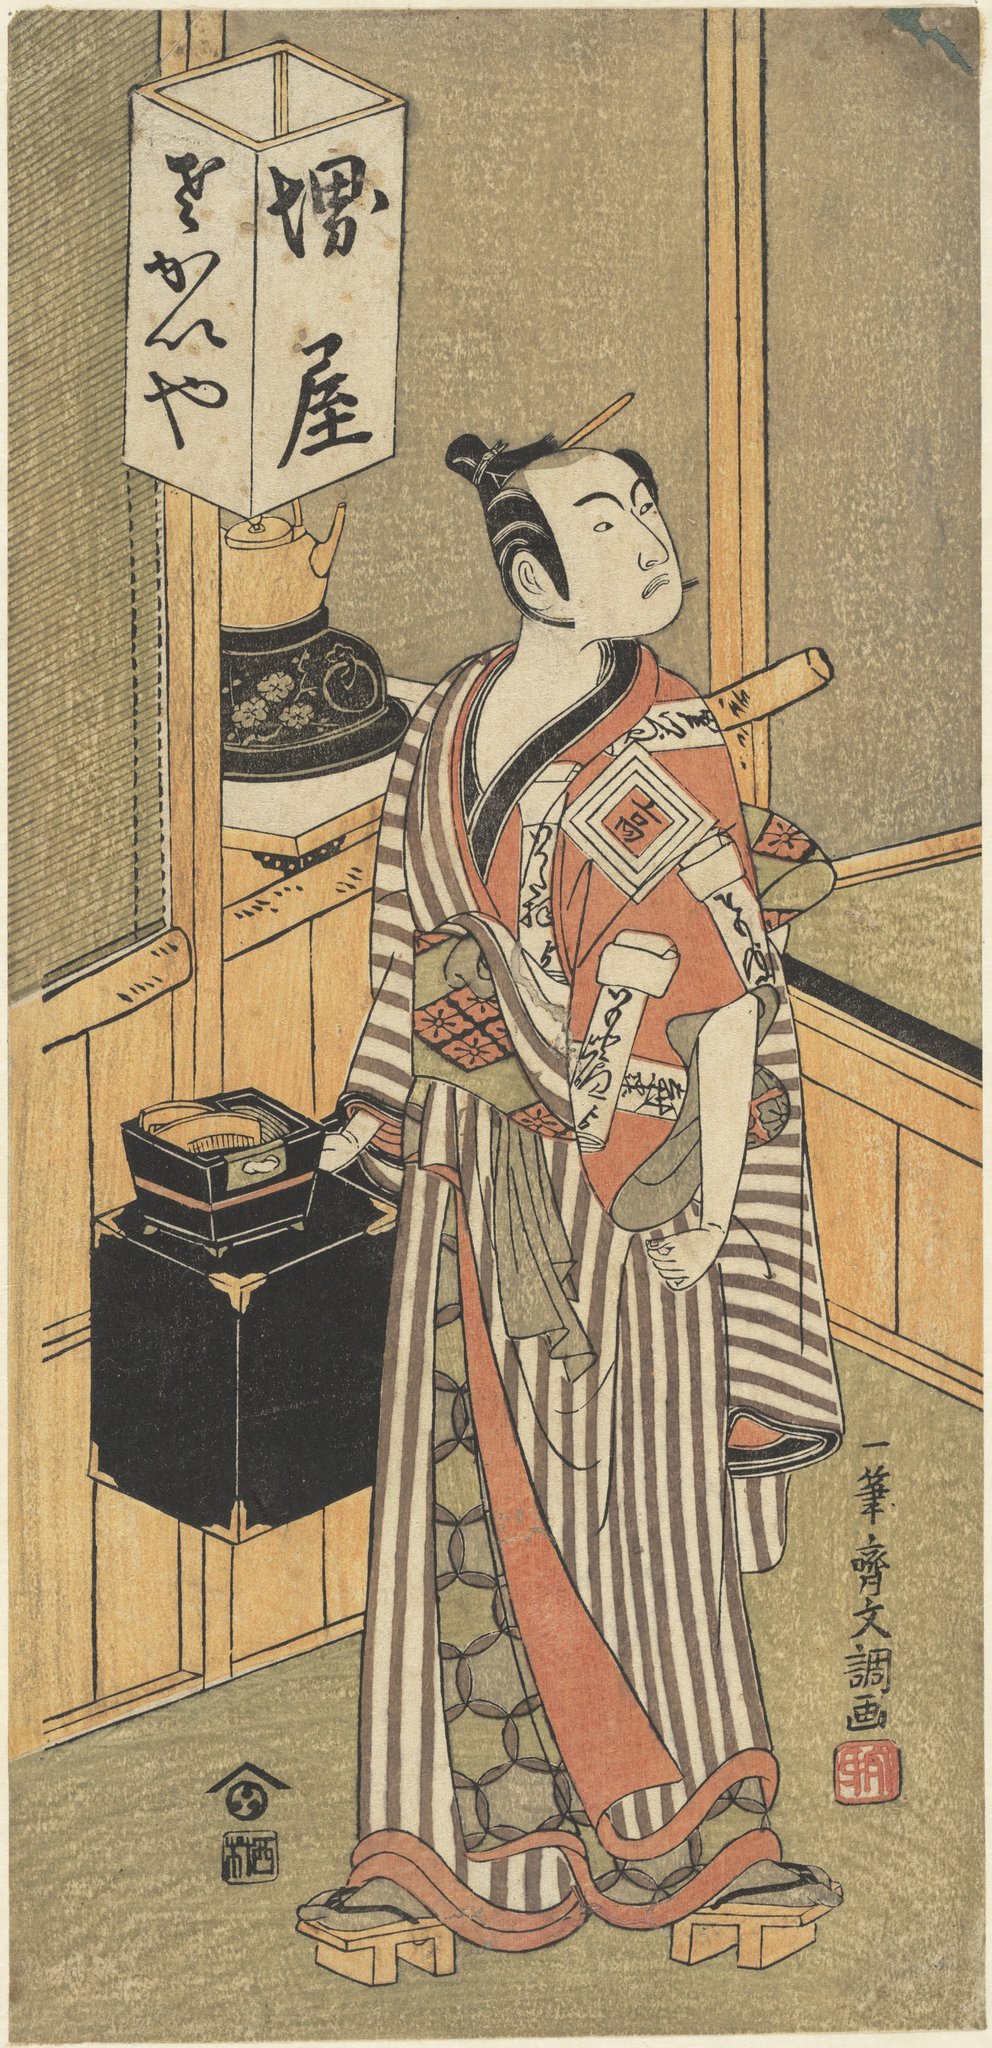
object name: print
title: Ichikawa Komazo I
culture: japanese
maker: ippitsusai bunchō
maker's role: artist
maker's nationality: japanese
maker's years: 1765-1792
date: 1769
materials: ink, paper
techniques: woodblock print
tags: men,actors